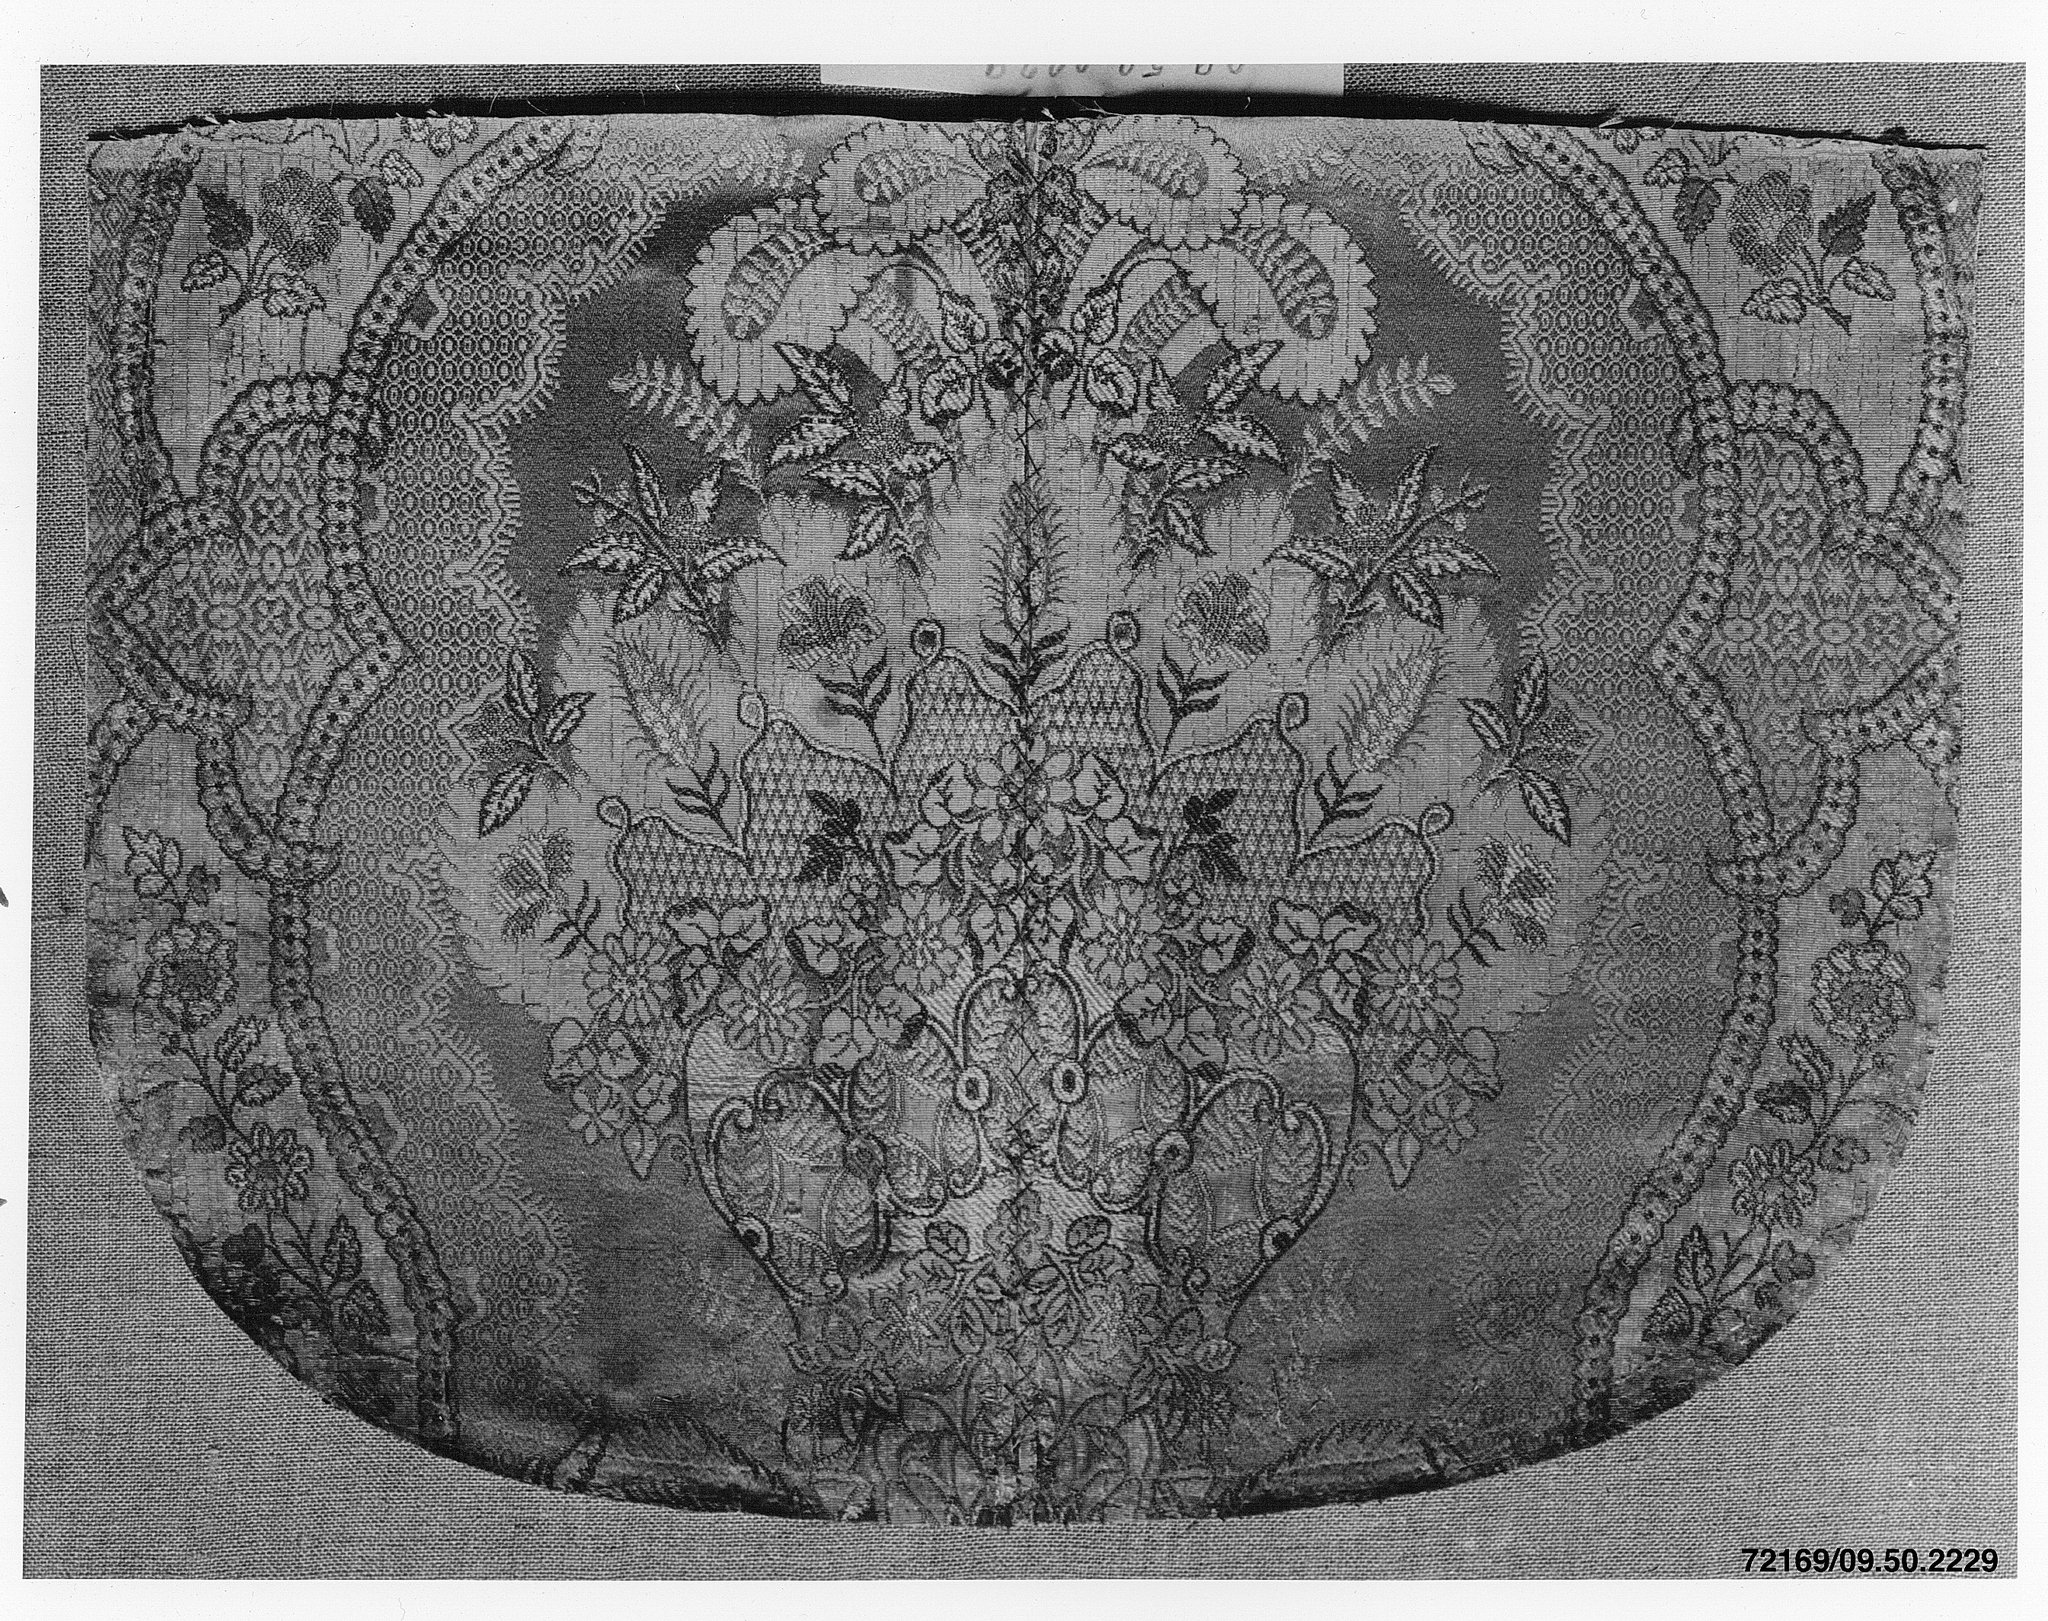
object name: piece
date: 1725-1730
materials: silk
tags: leaves